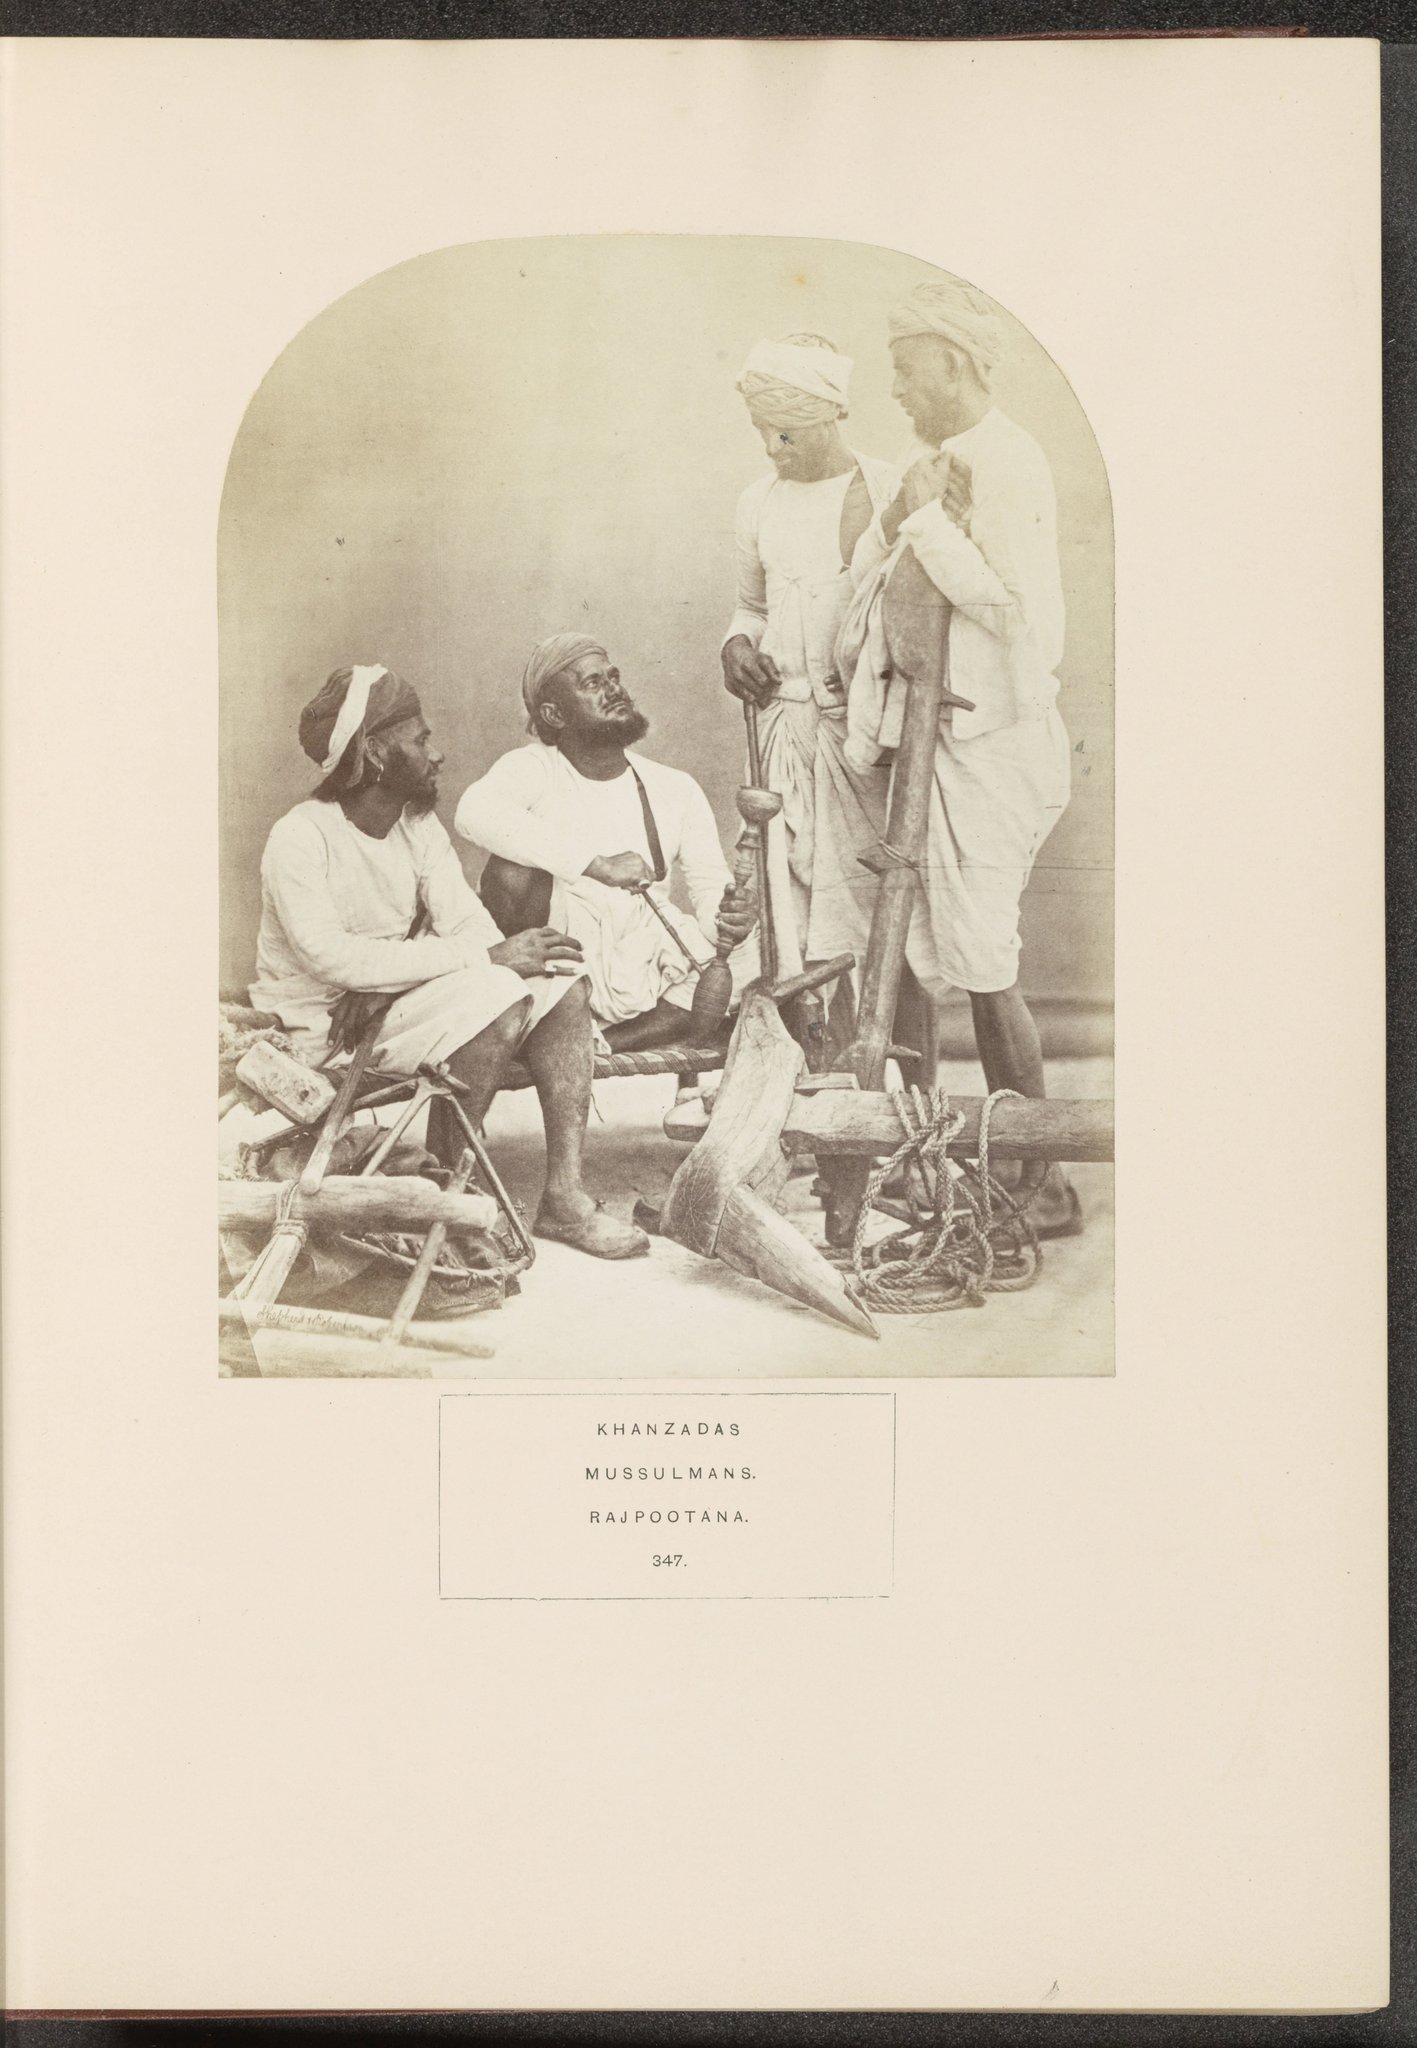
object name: photograph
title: Portrait of four unknown men from the Khanzada Rajput community with agricultural attributes, Rajasthan, India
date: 1860-1874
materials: photographic support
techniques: albumen print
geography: rajputana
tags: agricultural implements, human races; peoples; nationalities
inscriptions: number: ‘347.’, inscription: ‘KHANZADAS/ MUSSULMANS./ RAJPOOTANA.’